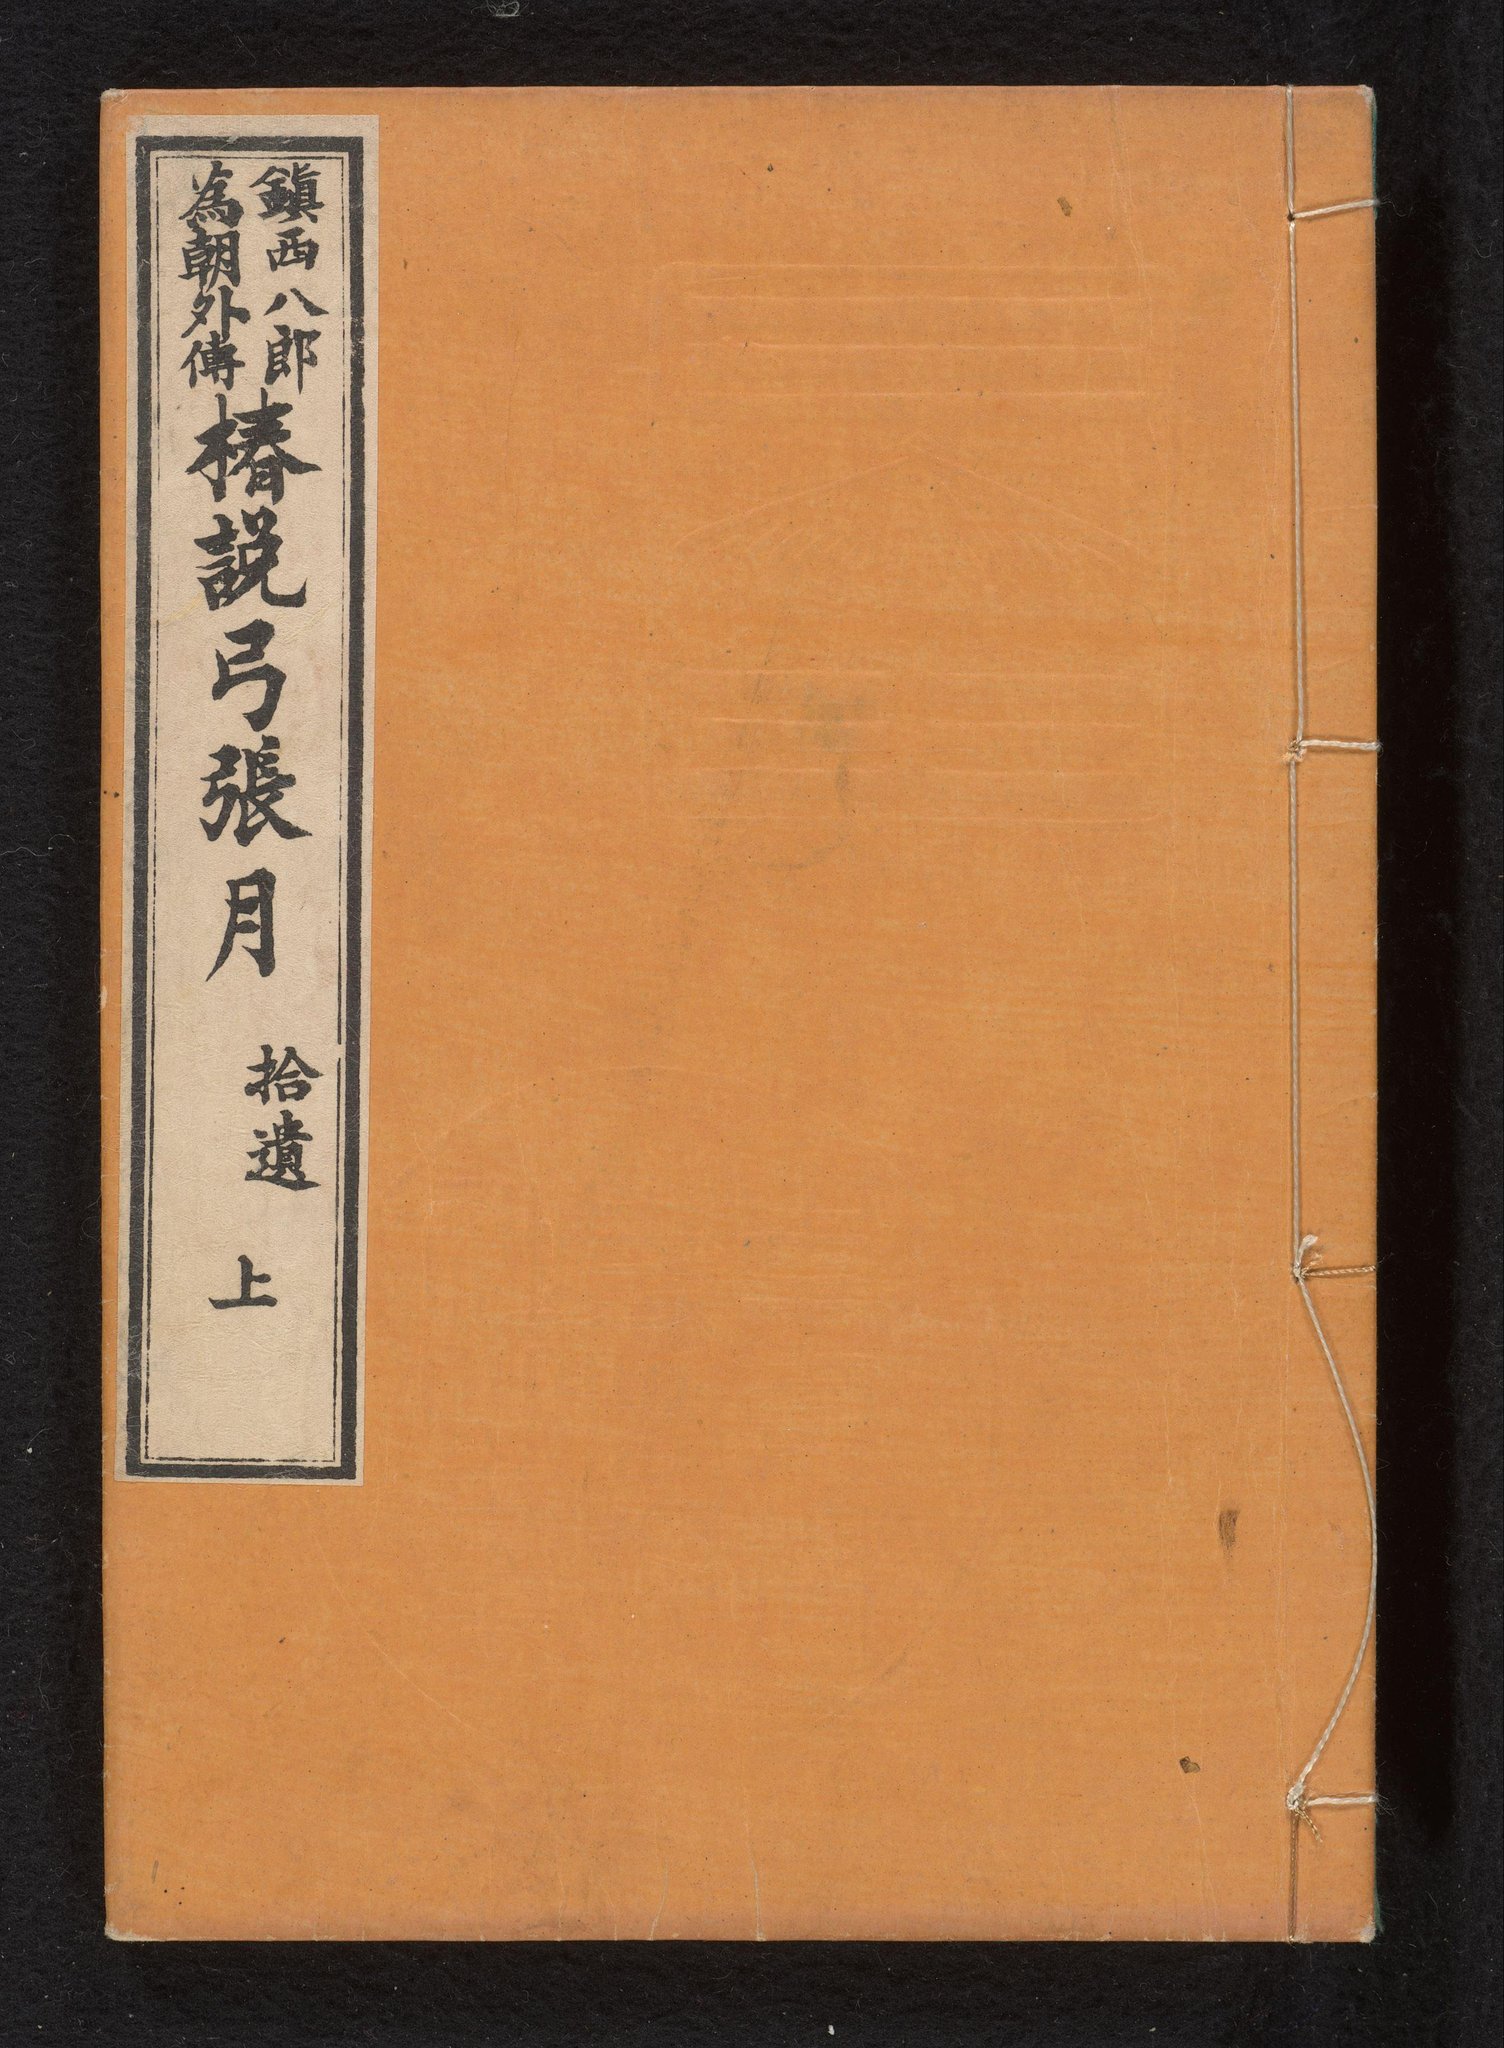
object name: book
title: De avonturen van Tametomo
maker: tsukioka yoshitoshi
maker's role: print maker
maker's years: 1839-1892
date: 1883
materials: paper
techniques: blind stamped, lithograph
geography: japan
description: Boek uit een tiendelige serie over de avonturen van de legendarische strijder Tametomo, geïllustreerd met 26 prenten gesigneerd door Tsukioka Yoshitoshi. De prenten zijn uitgevoerd in een combinatie van houtsnede en lithografie en gedrukt in zwart met een grijs toonblok. In originele banden met blinddruk.